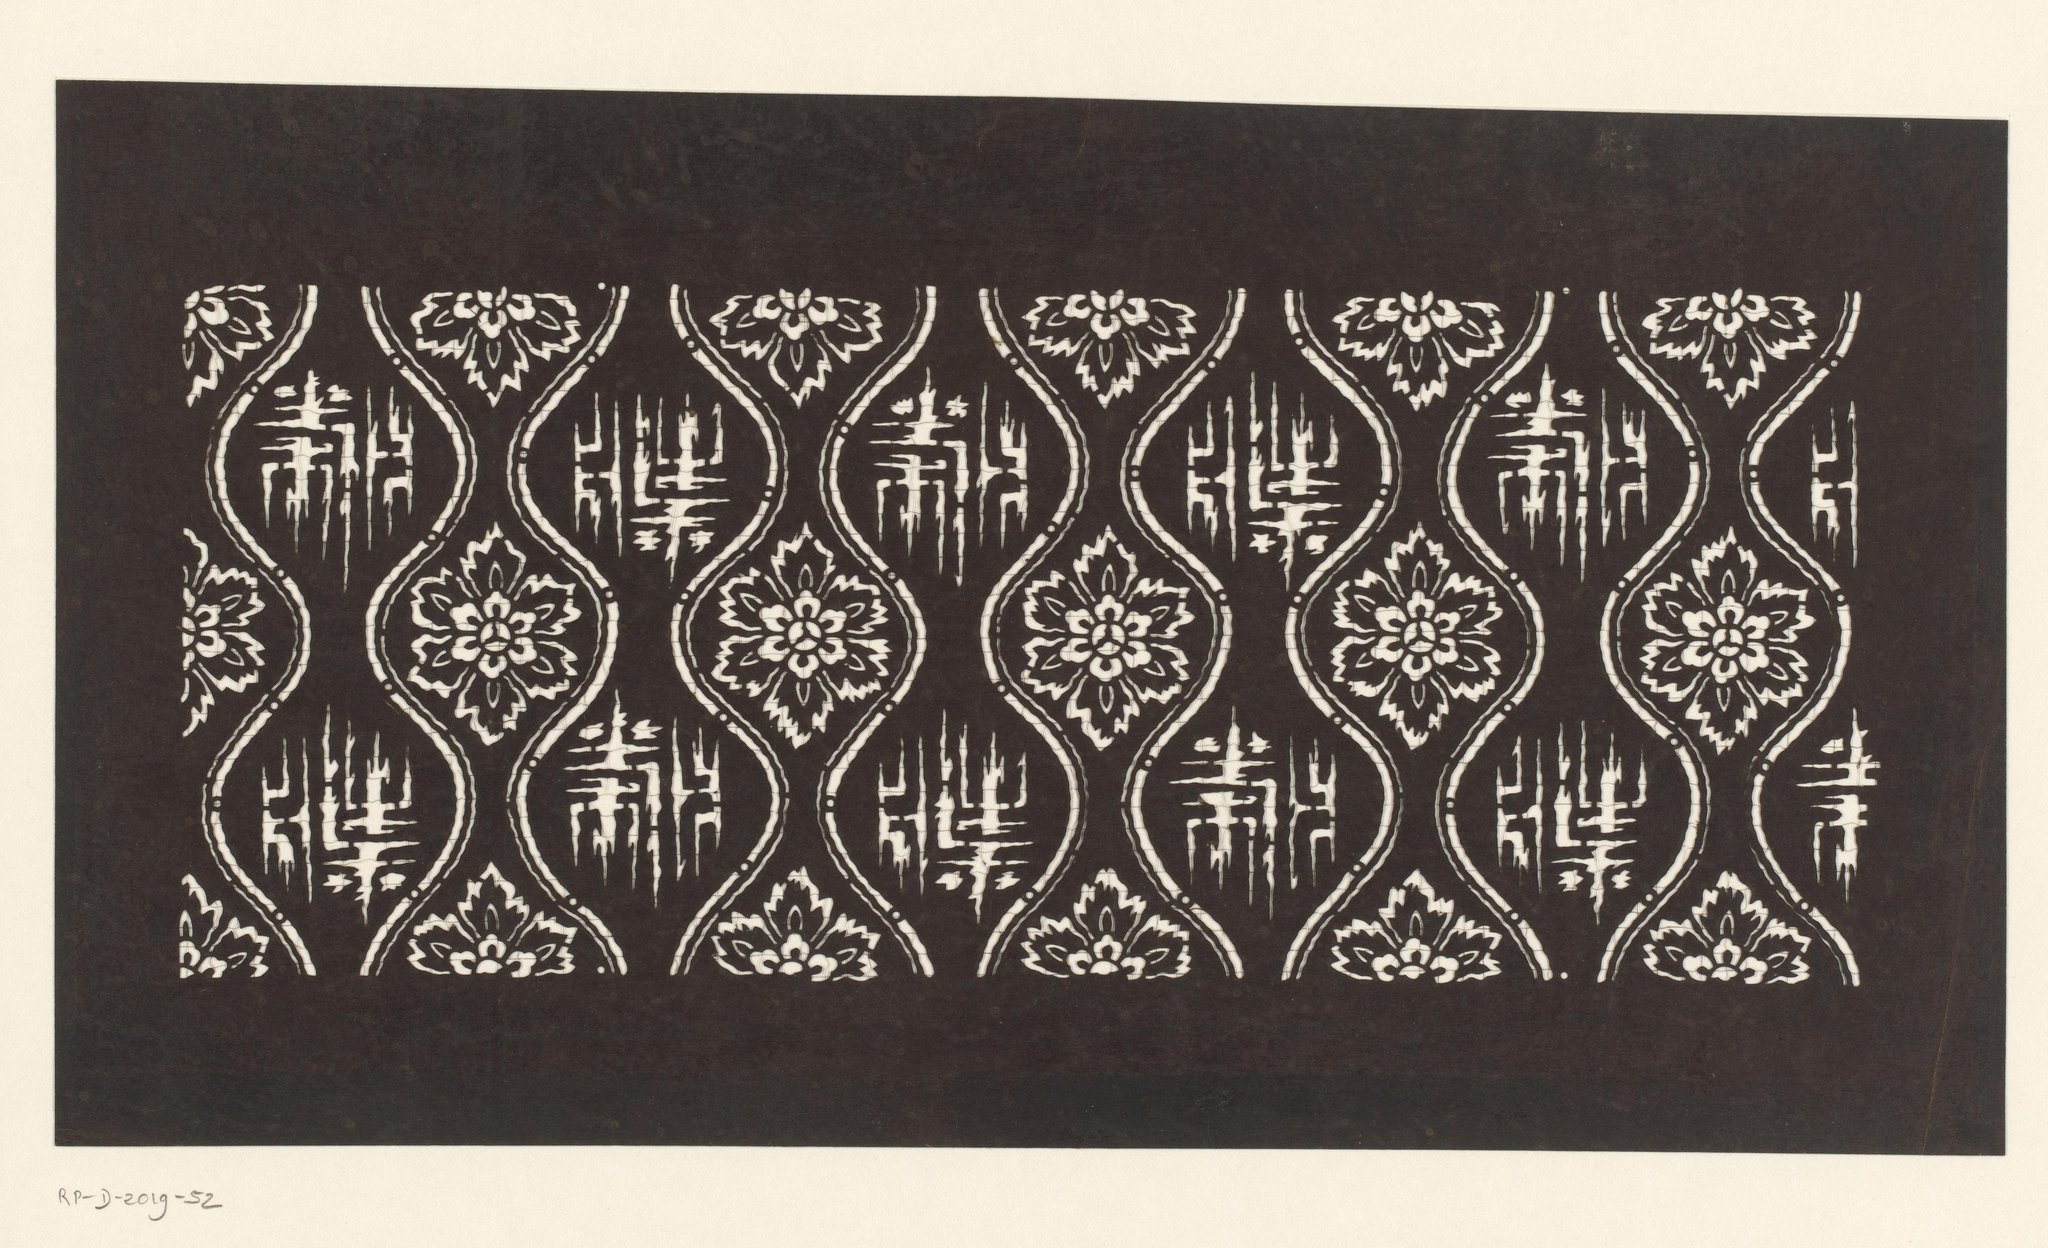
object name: katagami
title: Sjabloon met verticaal banenpatroon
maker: Anonymous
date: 1800-1909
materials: paper, silk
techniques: cutting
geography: japan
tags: ornament derived from plant forms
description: Japanse sjabloon (katagami) met een verticaal golvend banenpatroon met bloem- en lijnenmotief.